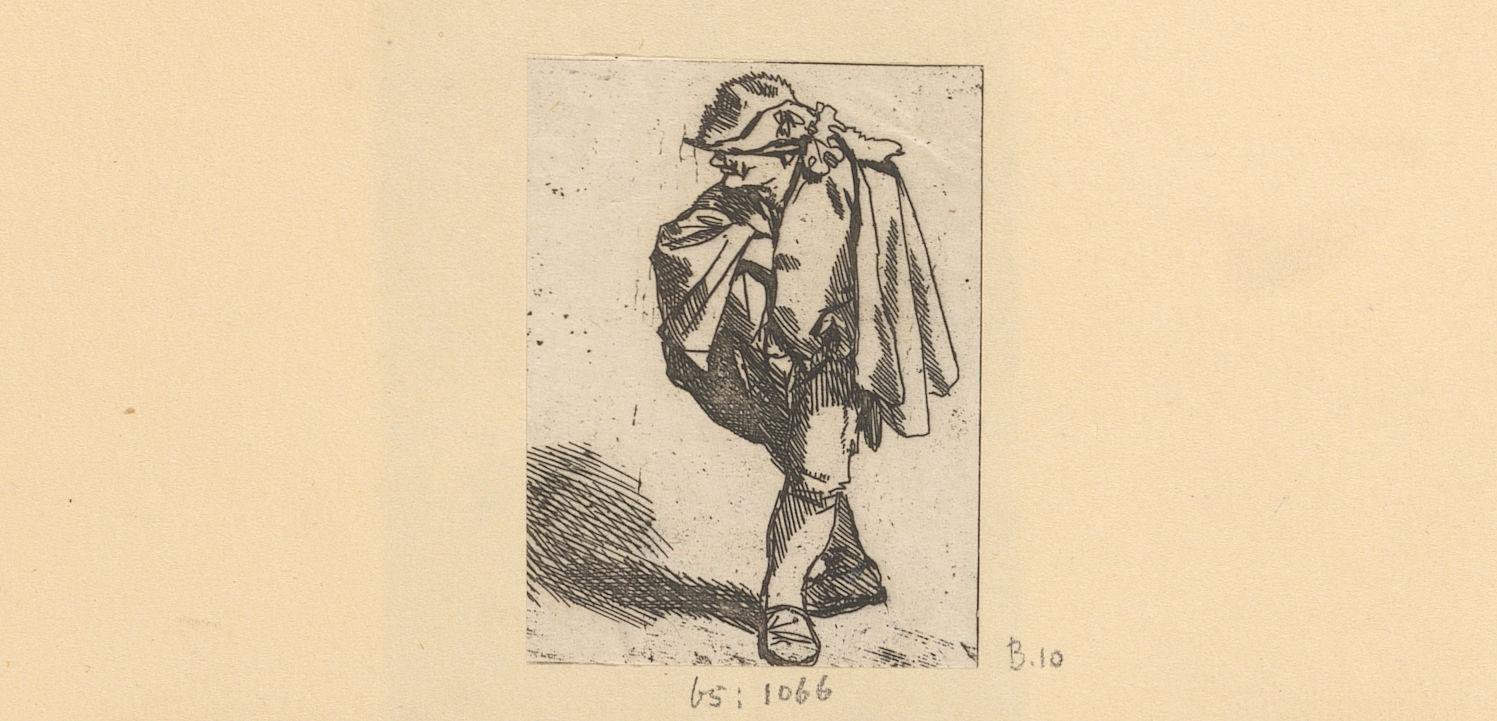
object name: album leaf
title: Man met mantel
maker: cornelis pietersz. bega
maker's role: draughtsman, painter, print maker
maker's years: 1631-1664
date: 1641-1664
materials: paper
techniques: etching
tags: adult man, coat, cape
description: Prent maakt mogelijk deel uit van een serie van 200 prenten. Deze serie is onder de titel 'A Collection of two hundred original etchings' voor het eerst uitgegeven door J.M. Greery in 1816.